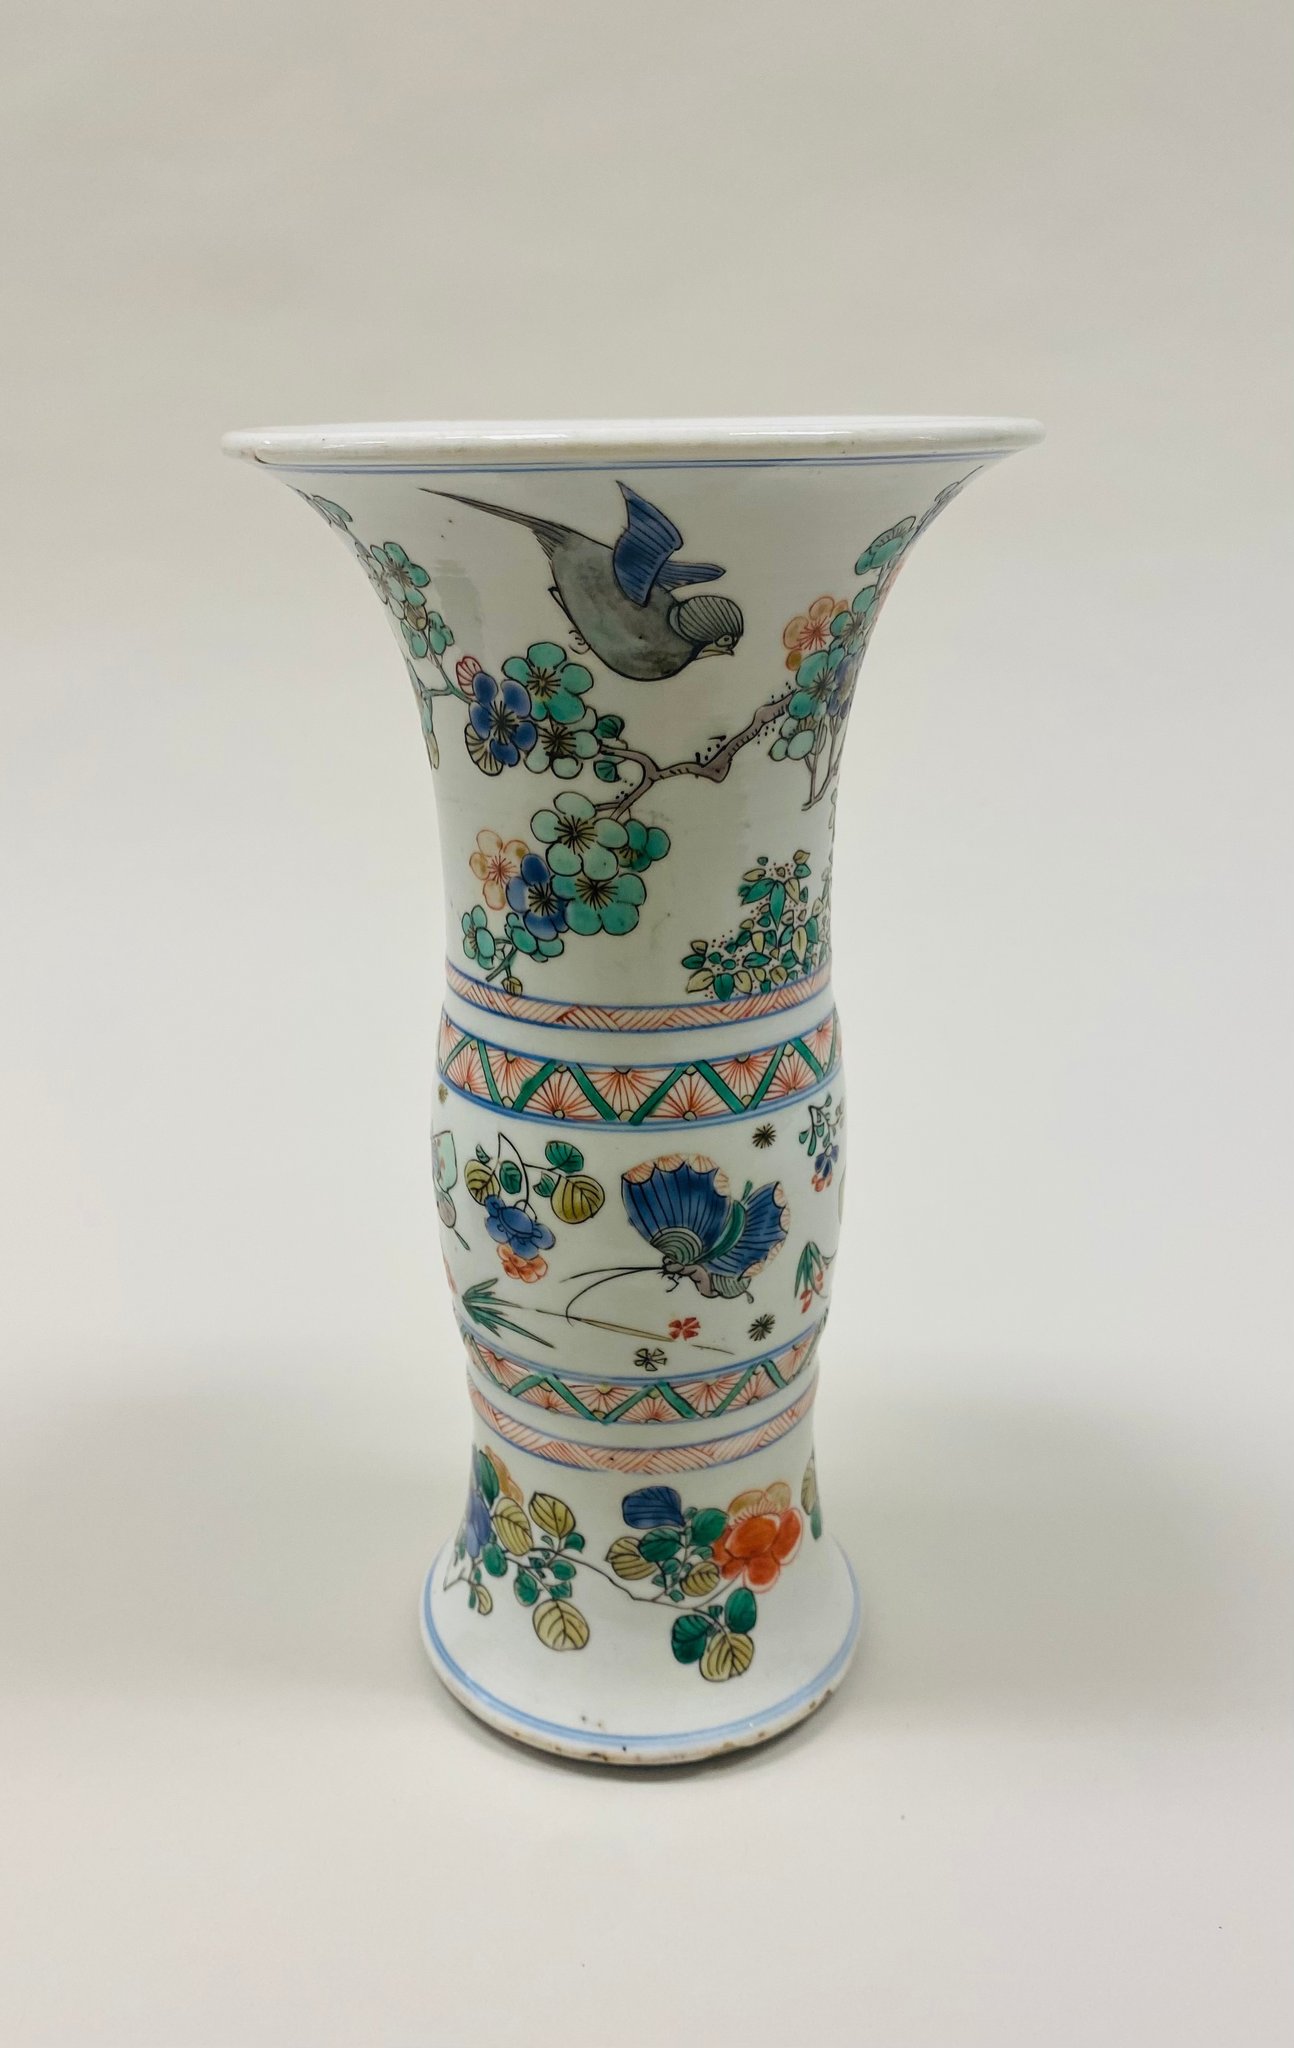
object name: vase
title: Vase with birds and flowers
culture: chinese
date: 1667-1733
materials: cobalt, enamel, porcelain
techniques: overglaze, painting, polychrome, underglaze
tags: birds,butterflies